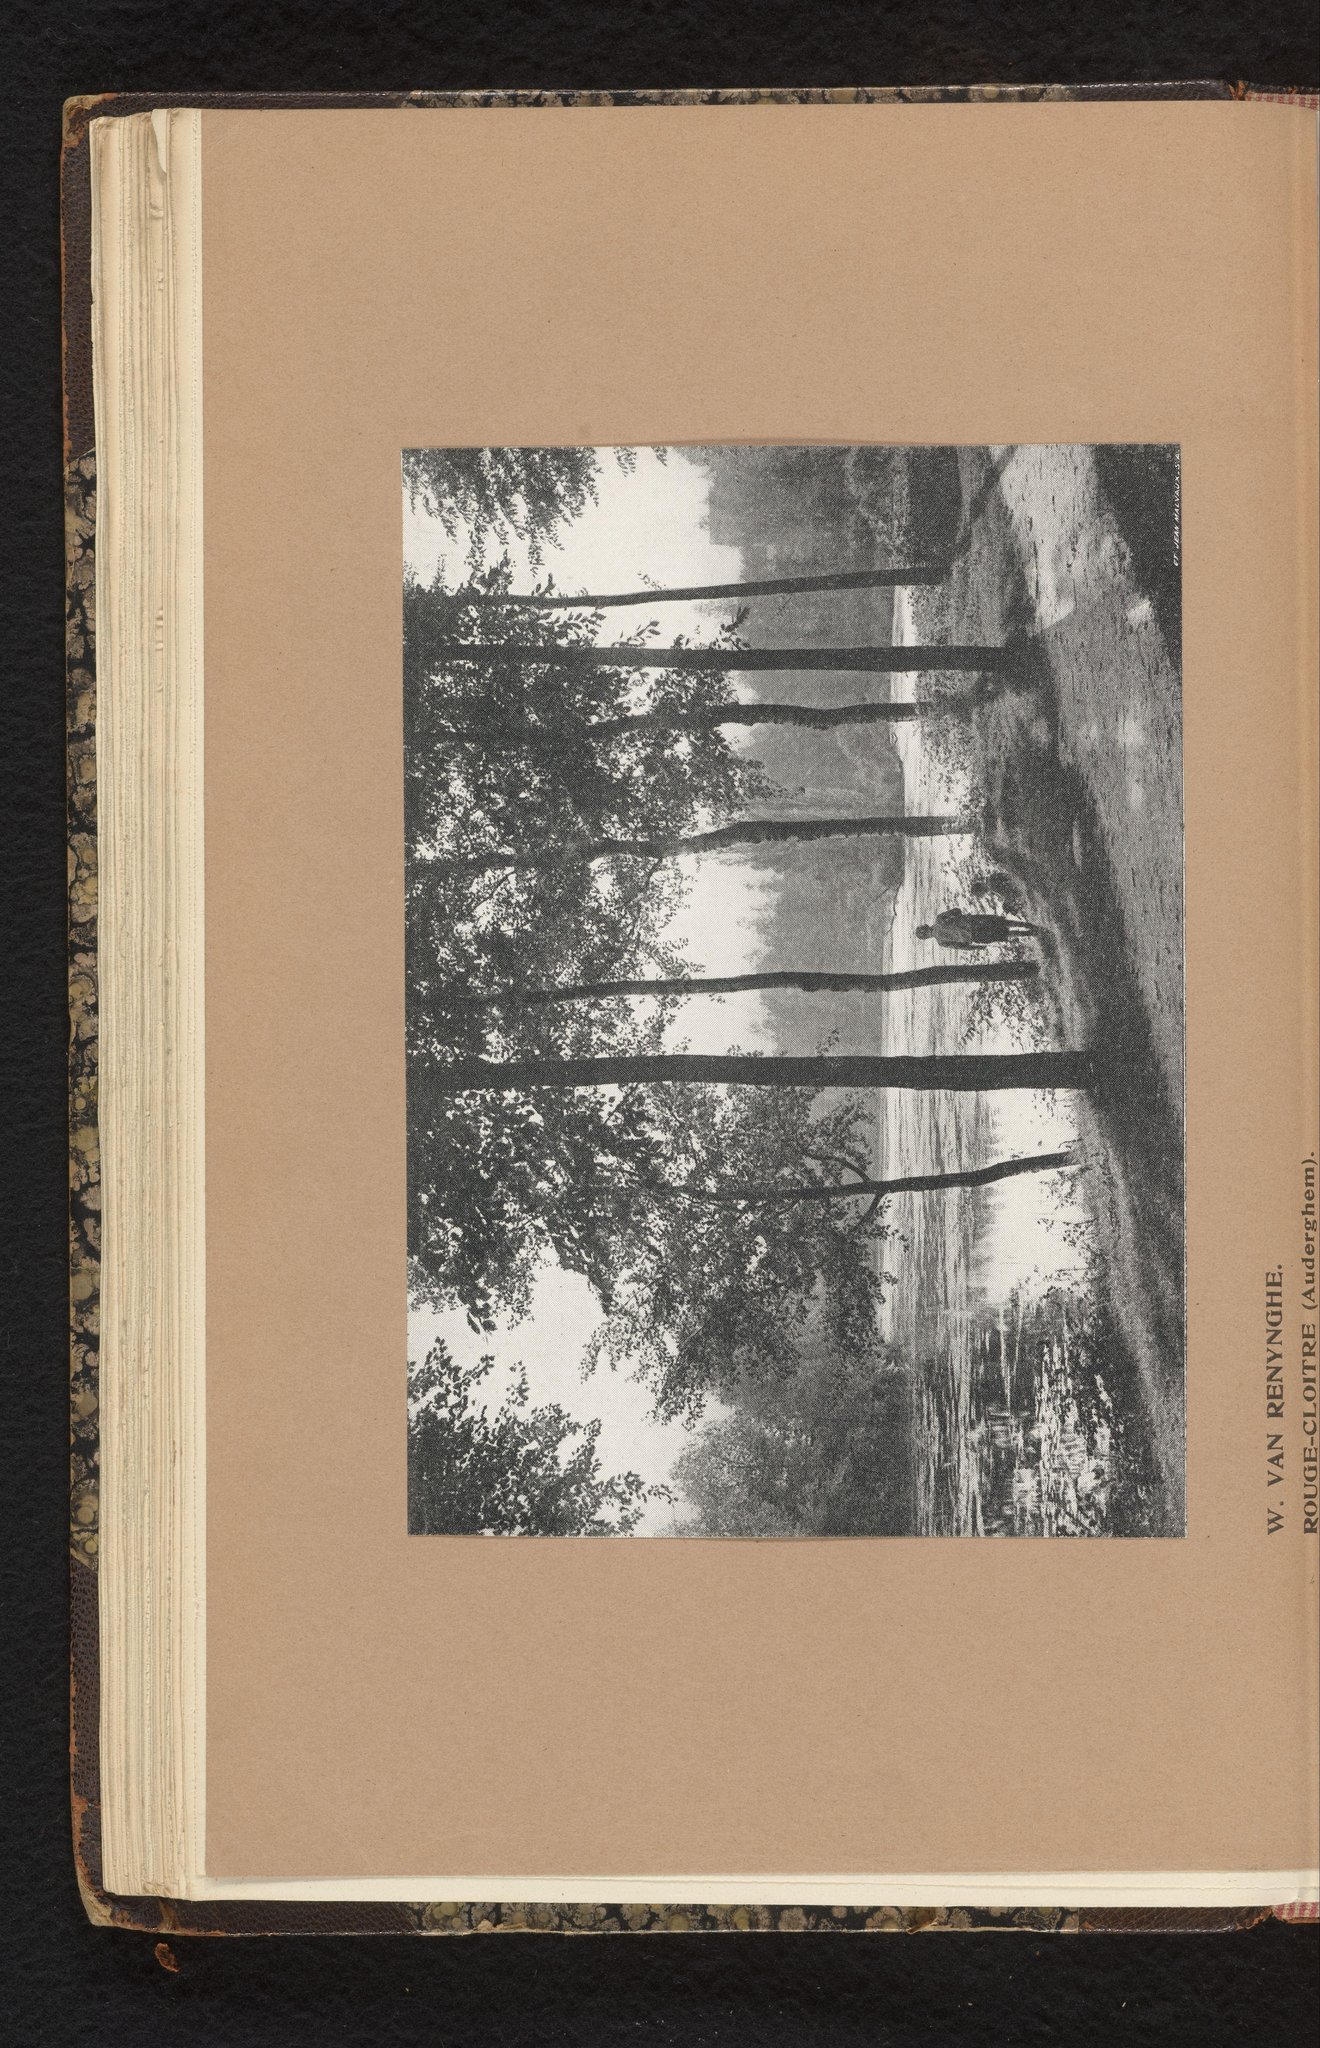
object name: page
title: Rouge Cloitre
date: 1897-1902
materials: paper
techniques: autotype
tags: historical persons, landscapes with waters, waterscapes, seascapes (in the temperate zone)